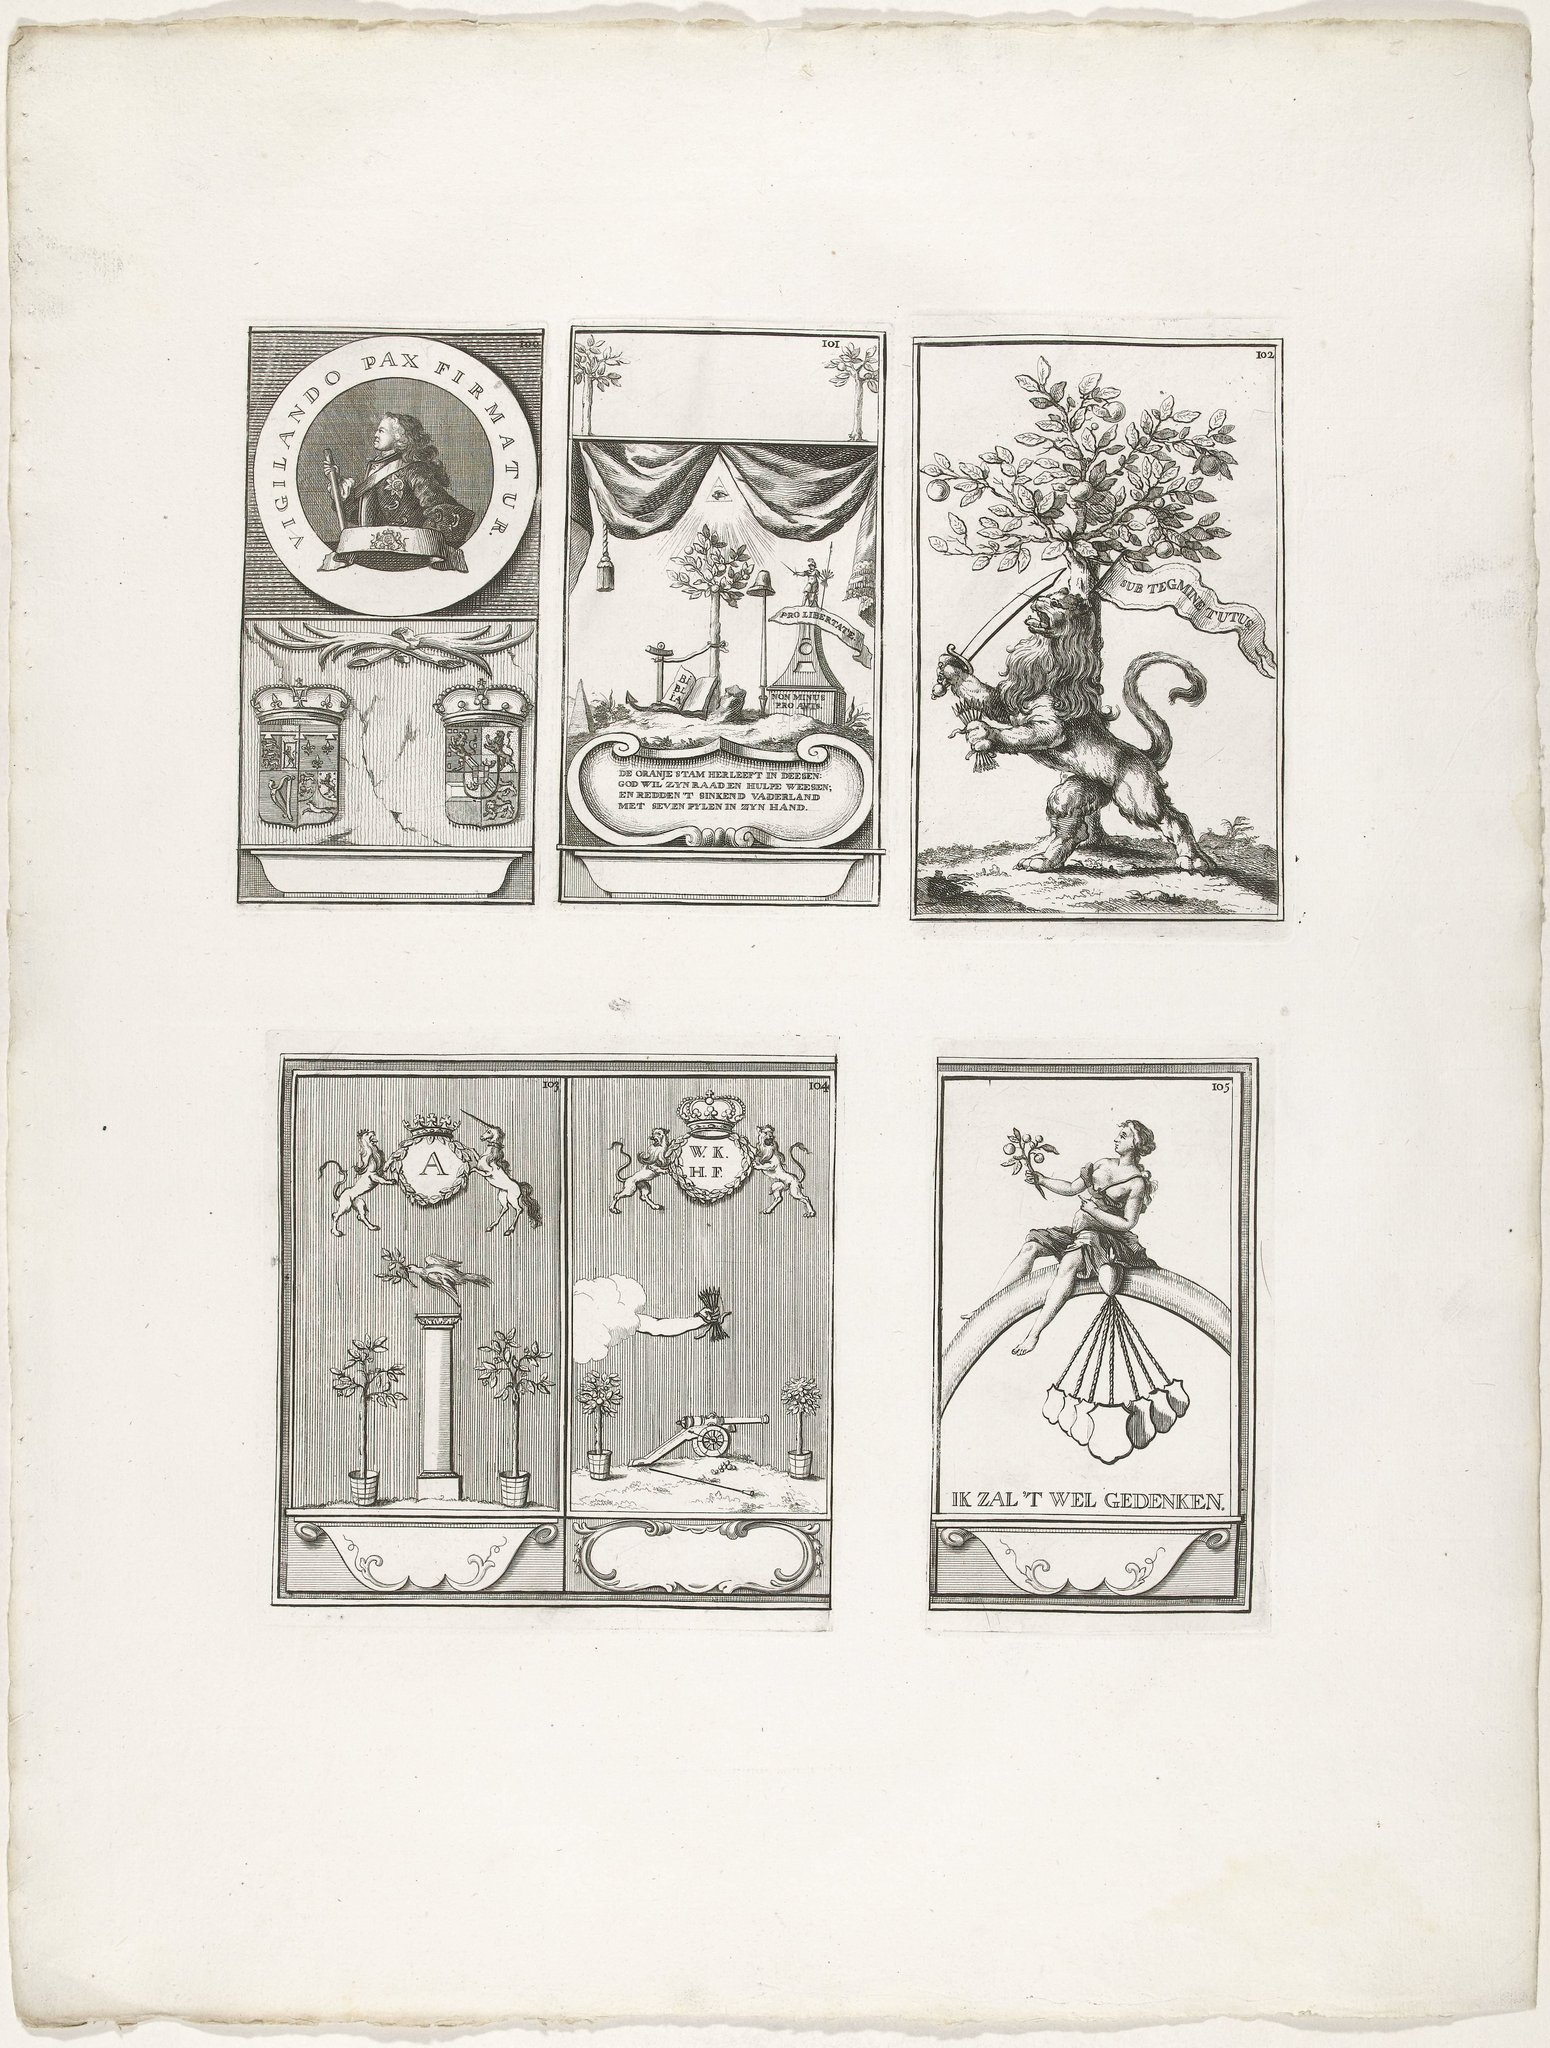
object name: print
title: Decoraties 100-105 te Den Haag, 1747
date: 1751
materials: paper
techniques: engraving, etching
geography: northern netherlands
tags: the hague, willem iv (prins van oranje-nassau), decoration and illumination of streets, squares, etc. (~ triumphal entry, etc.)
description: Blad met de decoraties aangeduid met de cijfers 100-105, opgehangen aan de huizen van inwoners van Den Haag. Los blad oorspronkelijk onderdeel van het plaatwerk Haga comitis illustrata uit 1751 met de versieringen opgesteld te Den Haag tijdens de feestelijkheden rond de installatie van prins Willem IV als stadhouder van Holland en West-Friesland op 3 en 15 mei 1747.